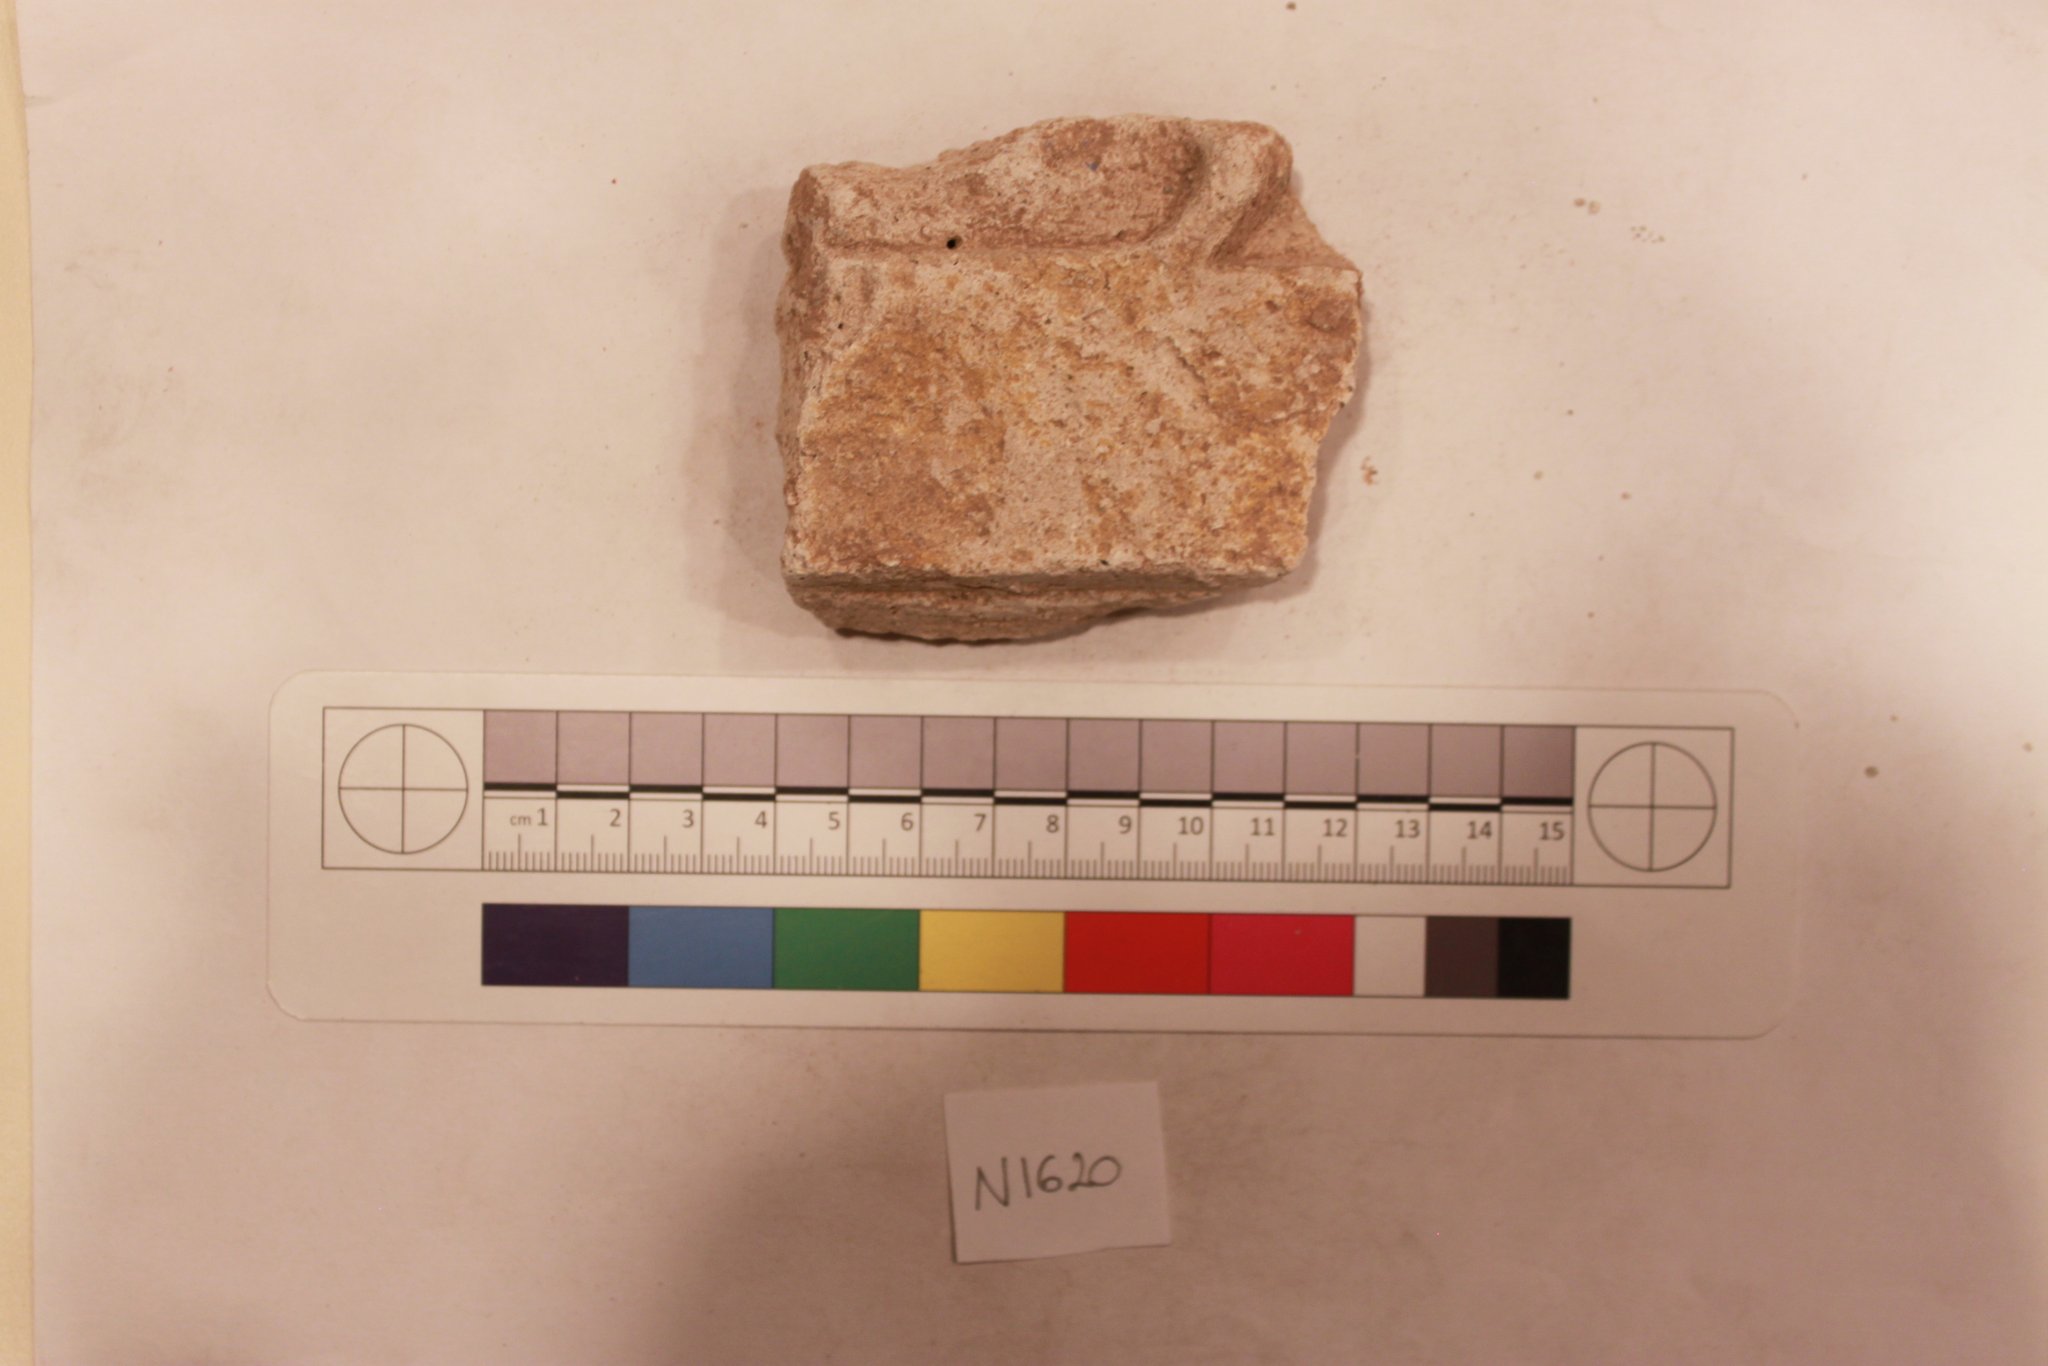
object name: fragment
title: Stucco Fragment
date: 701-1200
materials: plaster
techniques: carving, painting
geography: iran